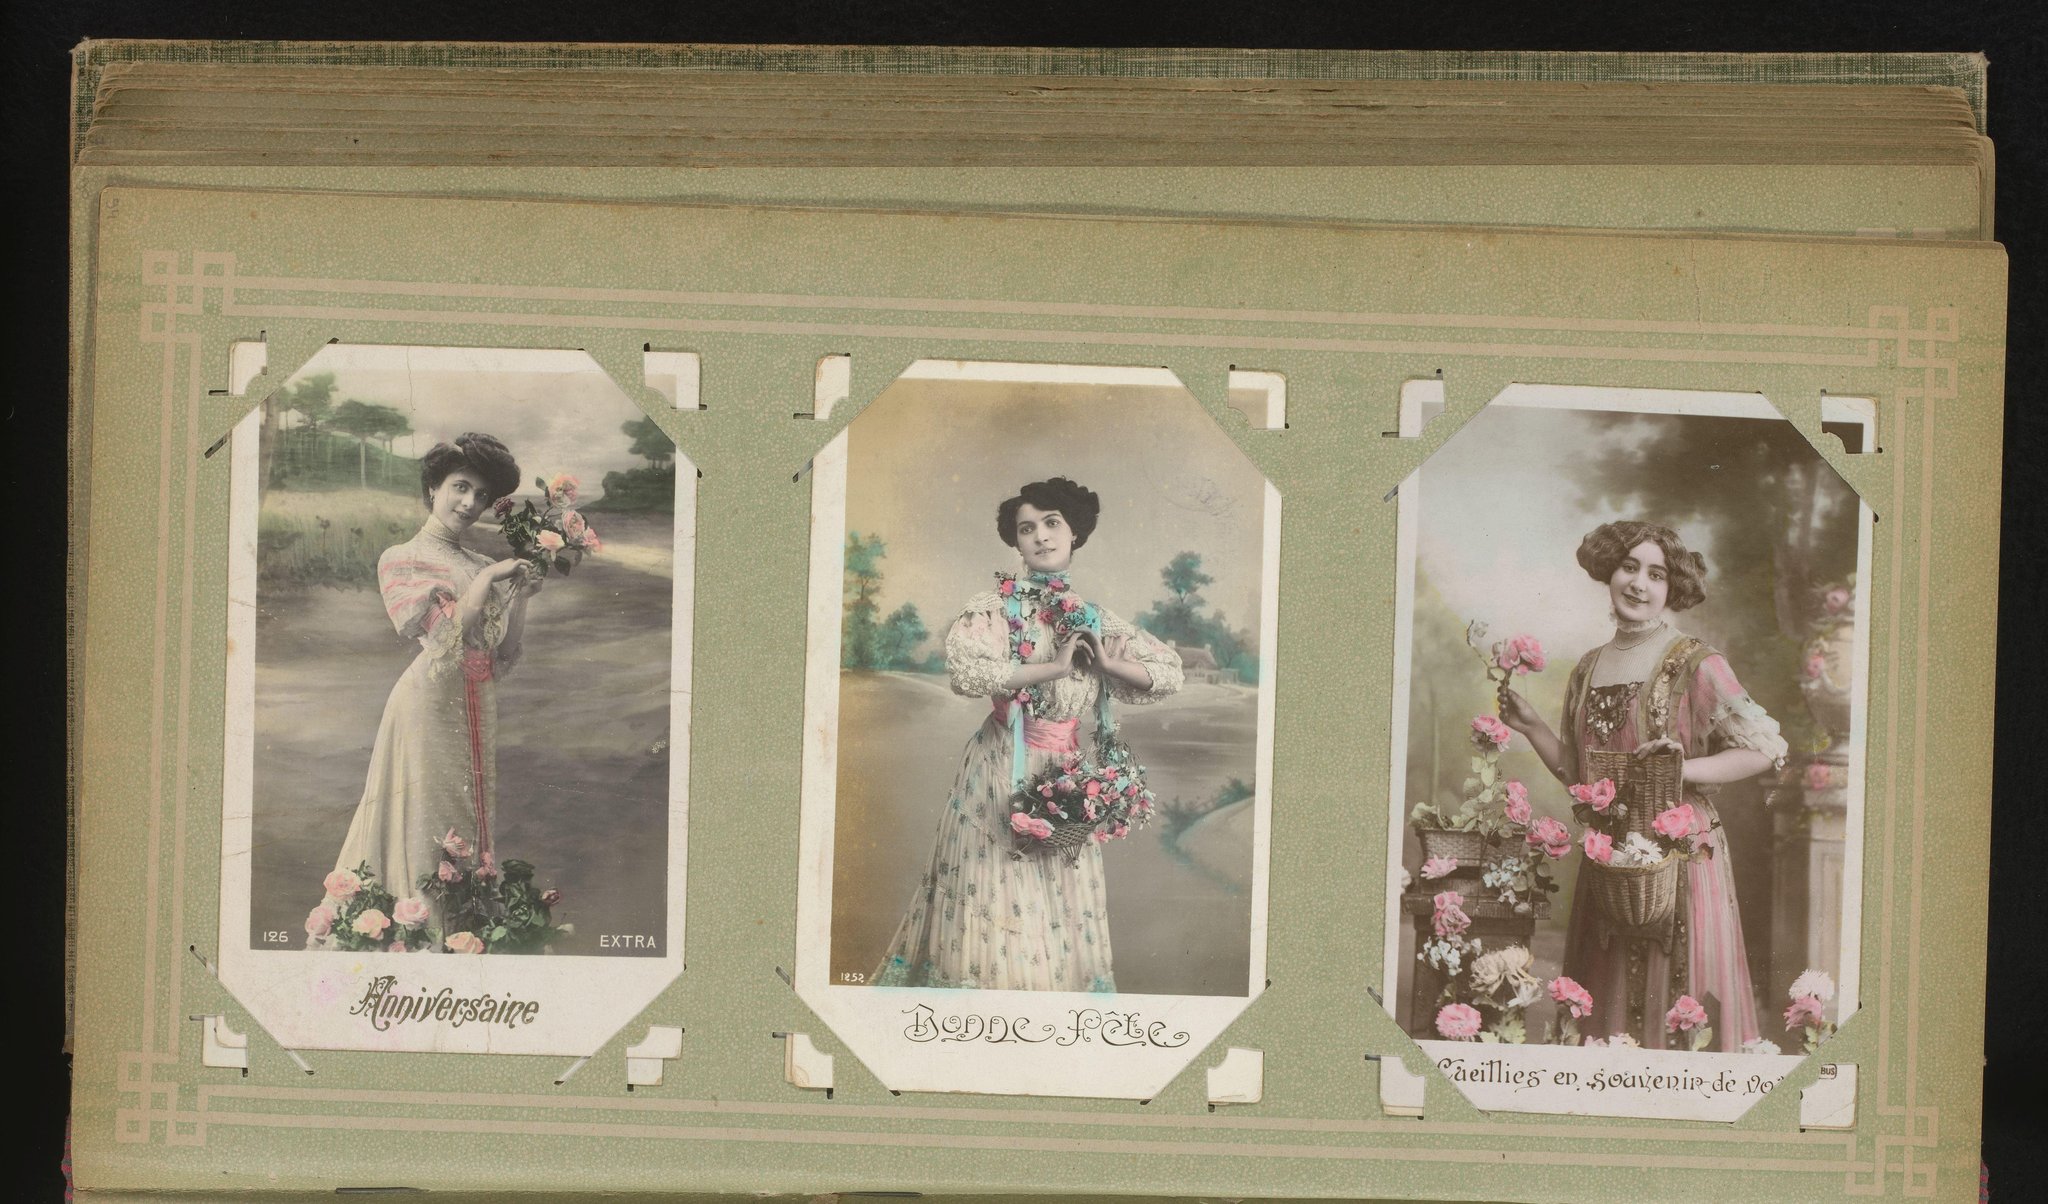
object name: photograph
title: Drie portretten van vrouwen met bloemen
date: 1900-1930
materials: cardboard, photographic support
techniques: gelatin silver print, hand coloring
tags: flowers, historical persons - bb - woman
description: Deze foto's maken deel uit van een album.